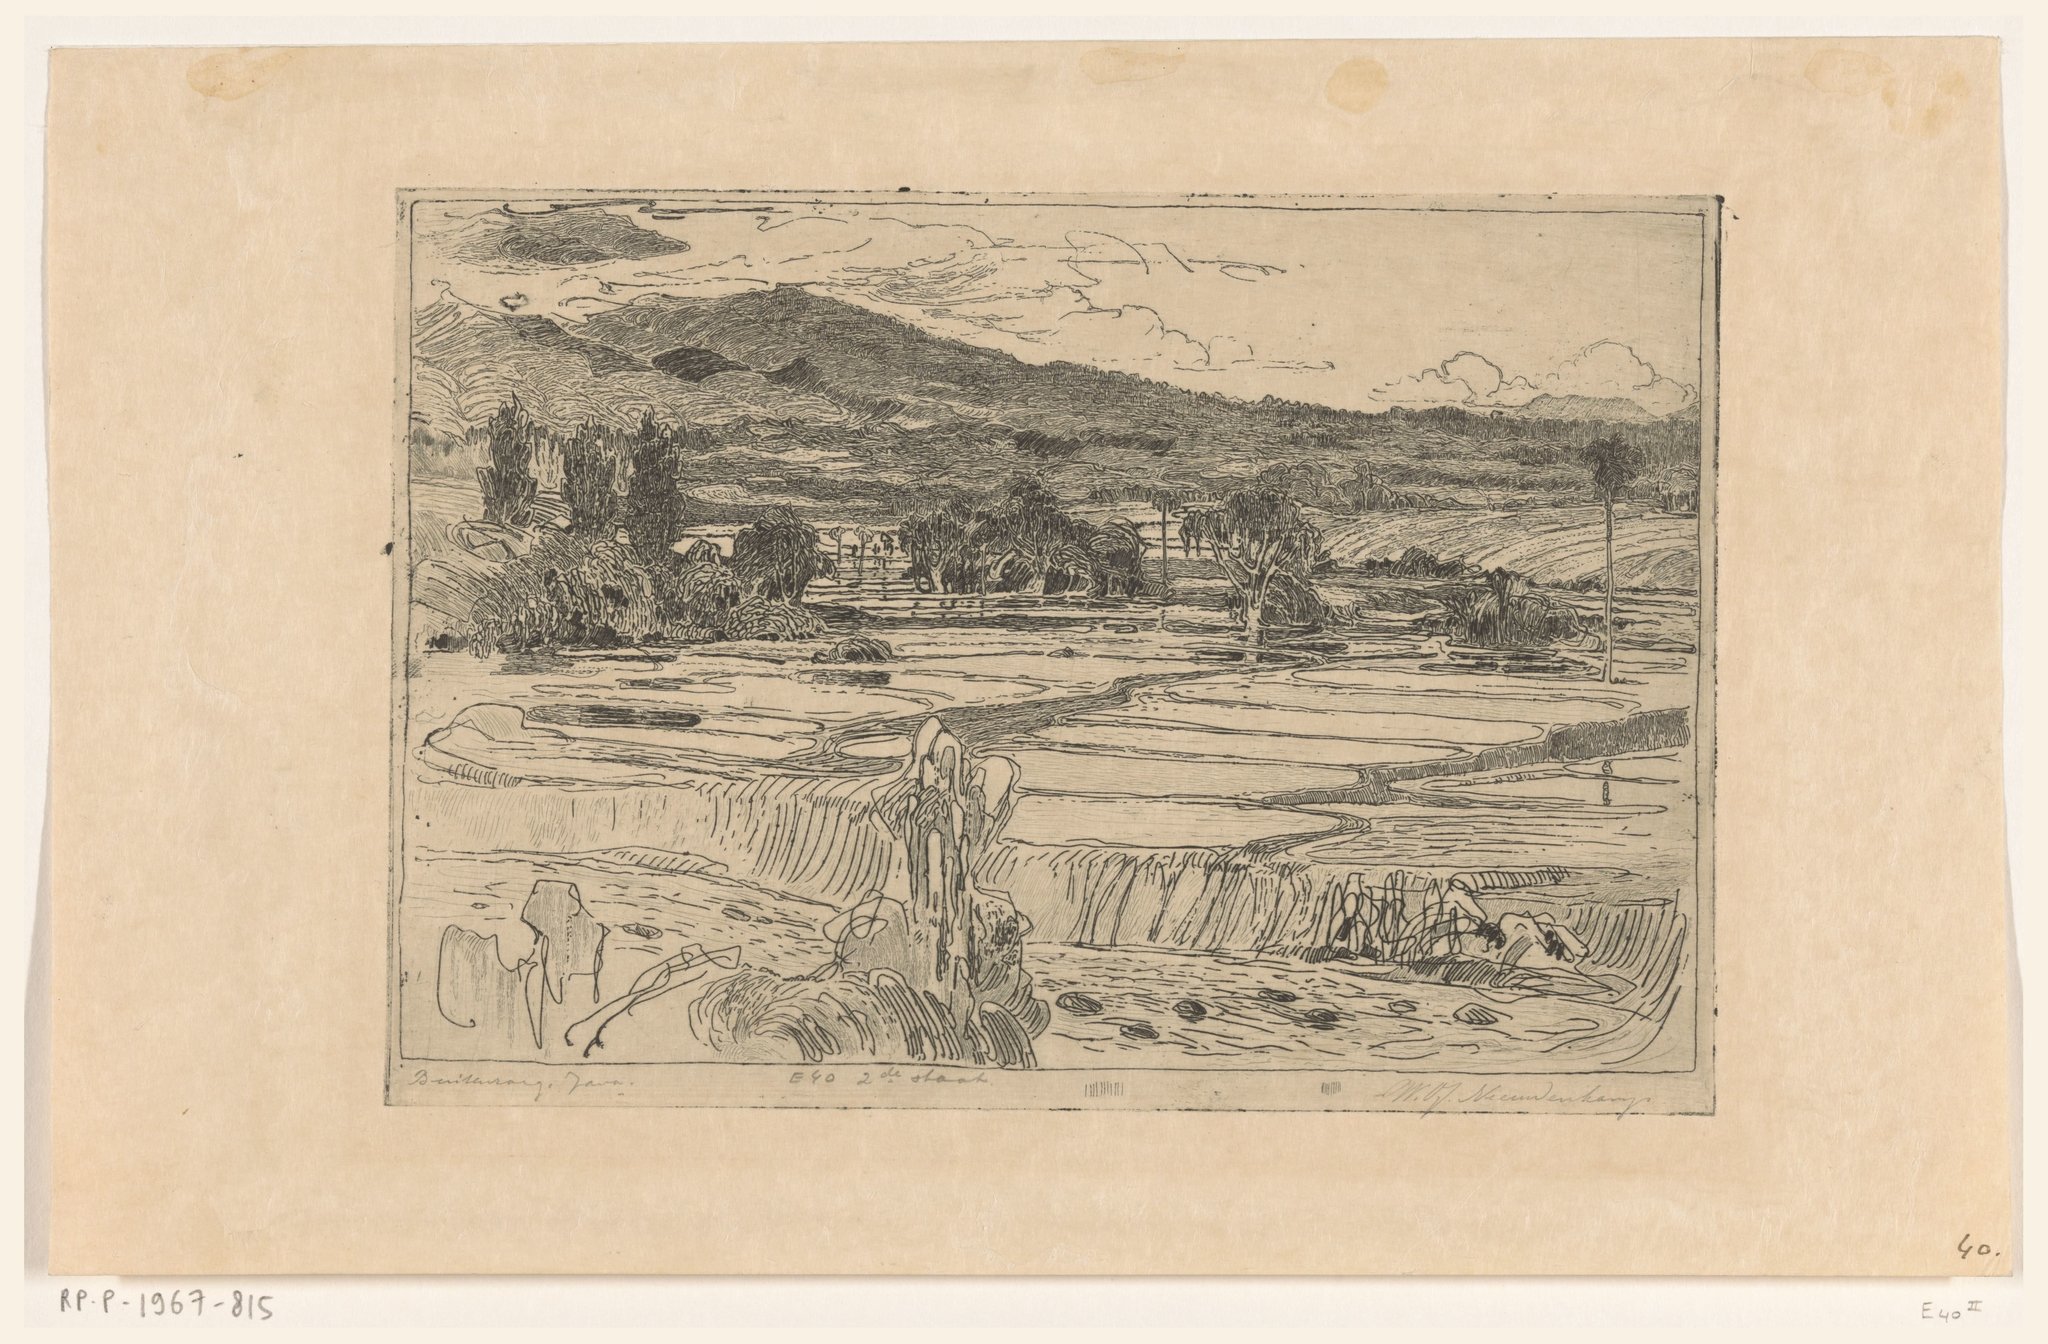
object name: print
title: Rijstvelden bij de vulkaan Salak op Java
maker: wijnand otto jan nieuwenkamp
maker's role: draughtsman, print maker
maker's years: 1874-1950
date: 1899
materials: paper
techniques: intaglio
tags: sawahs, rice paddies, volcano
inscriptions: collector's mark: Lugt 2228, collector's mark: Lugt 2760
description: Op de voorgrond een rivier en rijstvelden. Op de achtergrond de vulkaan Salak, gelegen ten zuidwesten van Buitenzorg, het tegenwoordige Bogor.